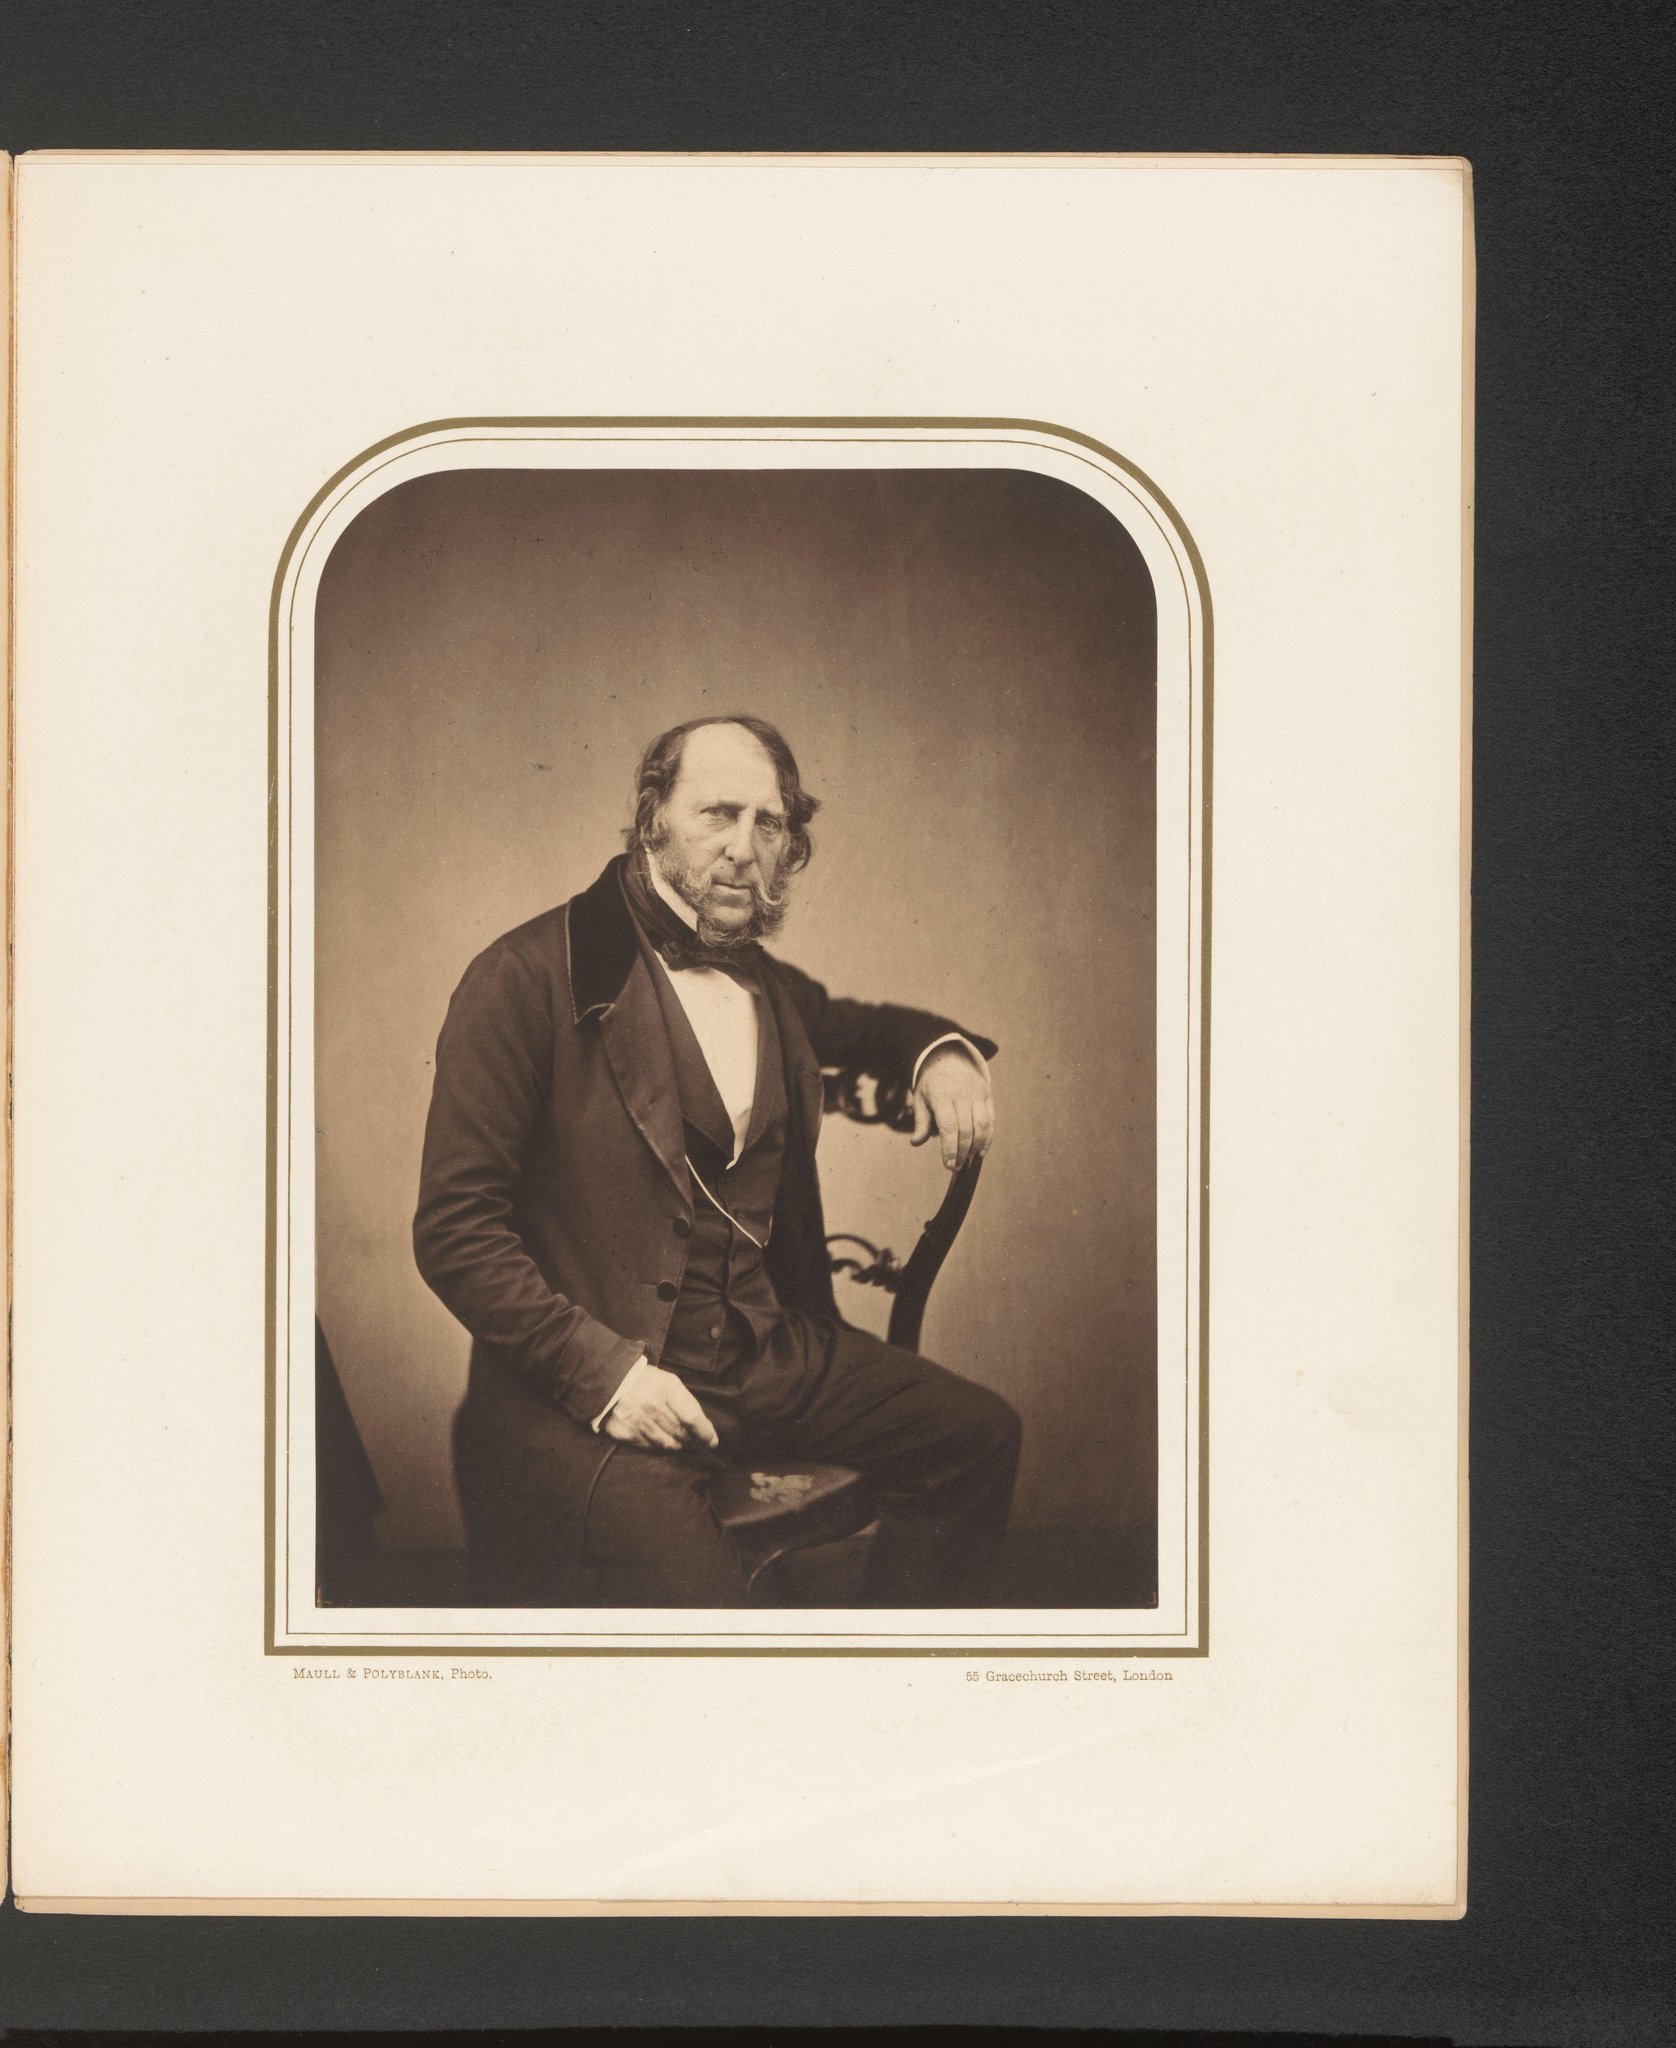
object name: page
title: Portret van George Cruikshank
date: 1853-1857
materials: photographic support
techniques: albumen print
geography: london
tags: london, painter, print maker, george cruikshank, historical persons, graphic artist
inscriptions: inscription: ‘55 Gracechurch Street, London’